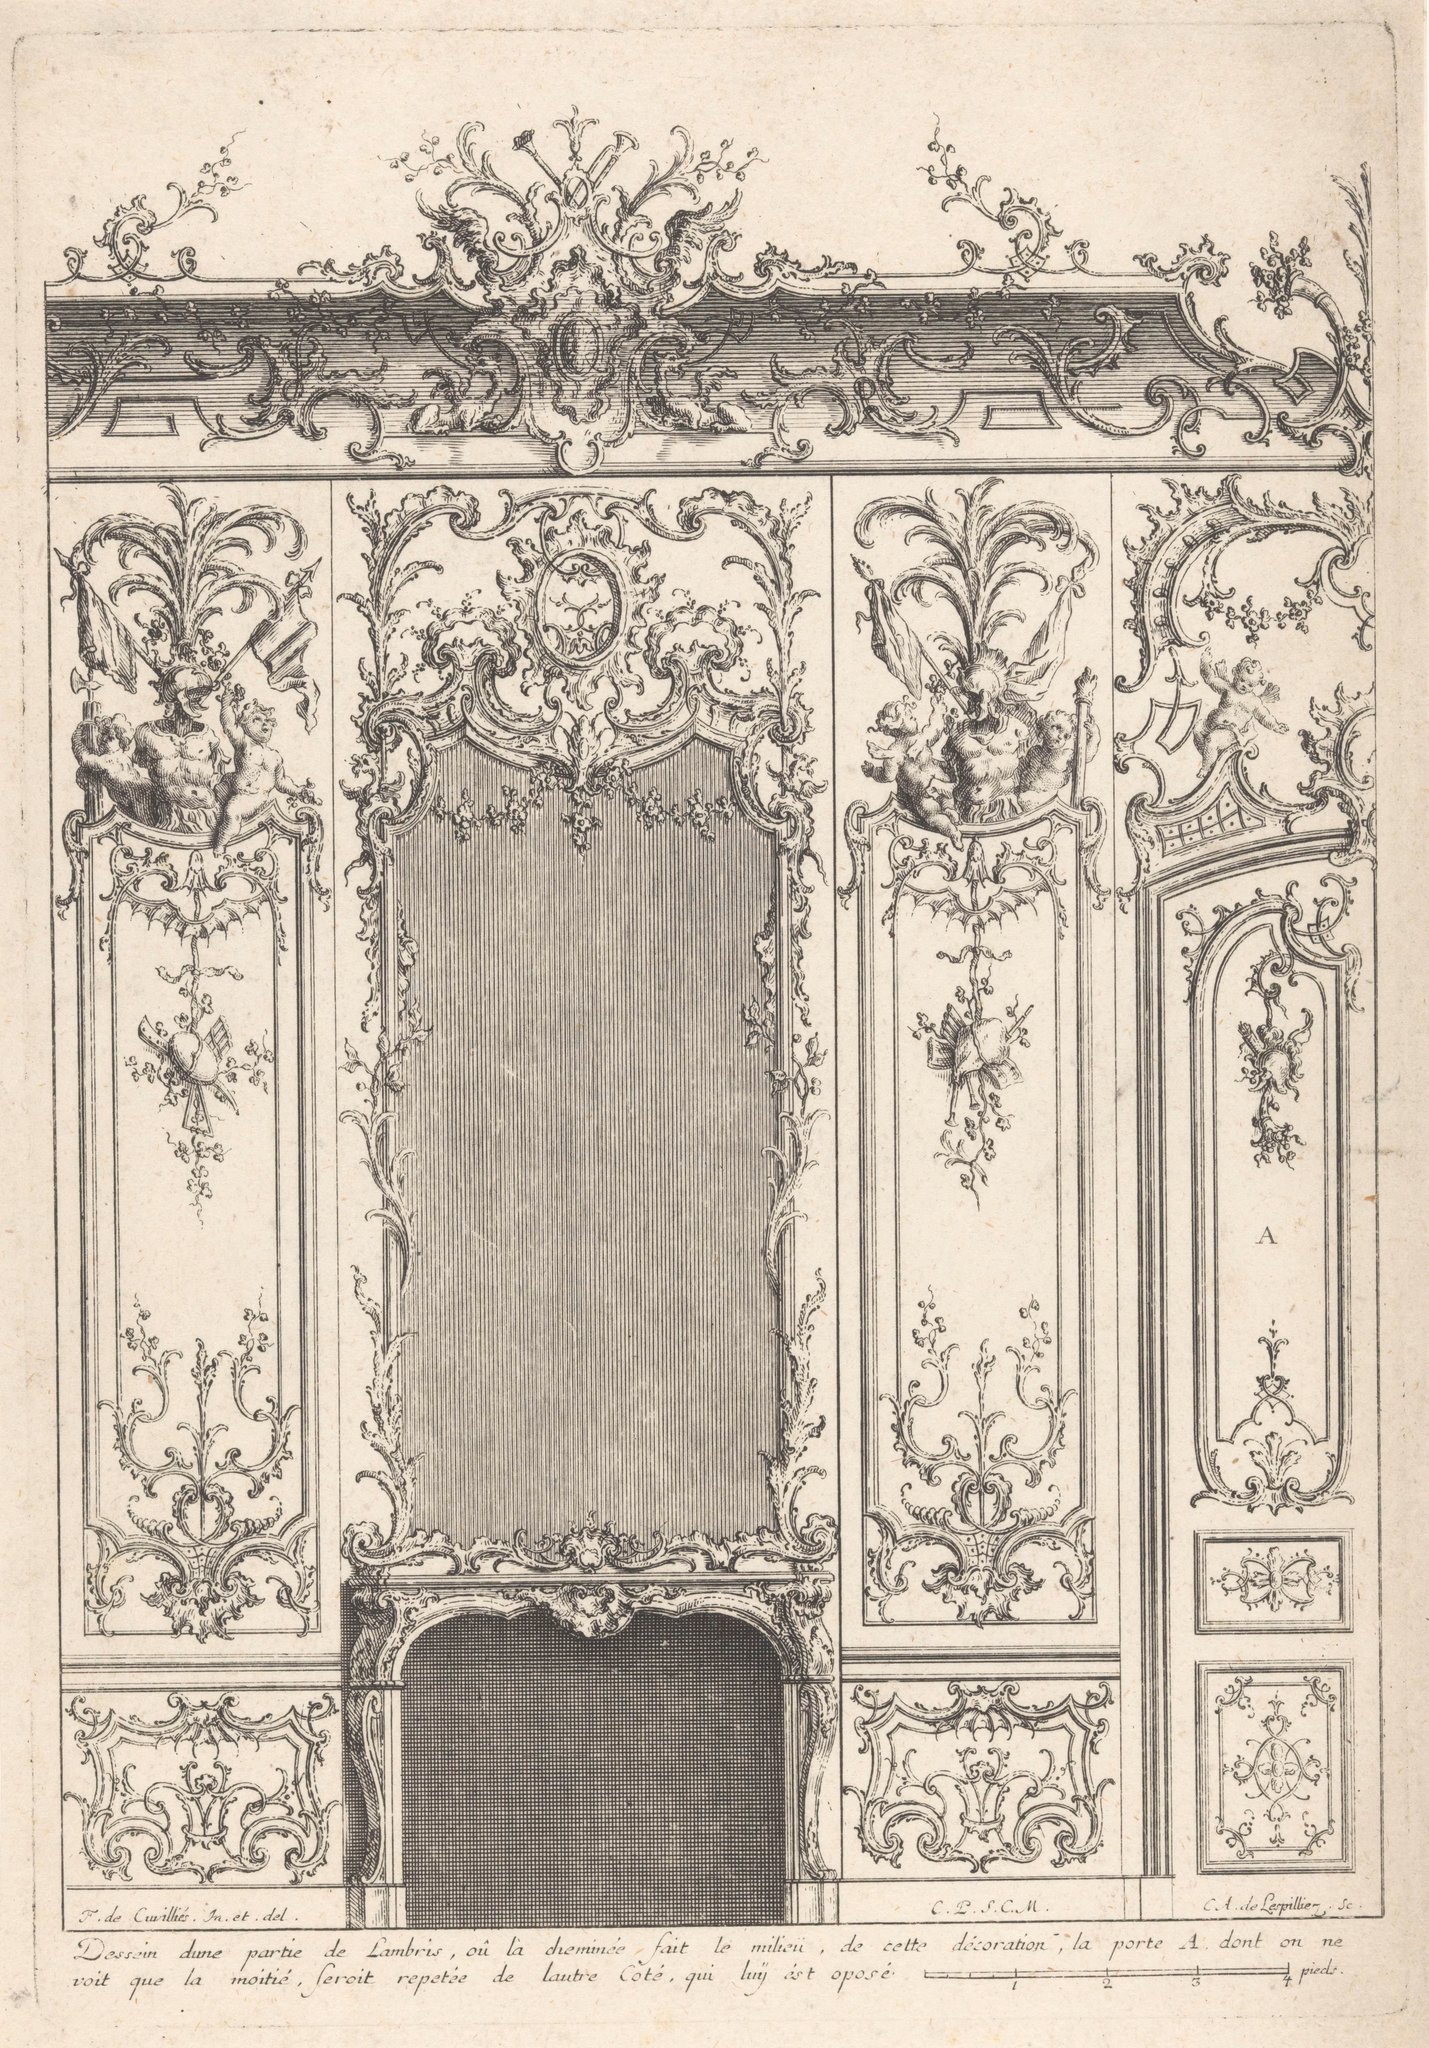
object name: ornament print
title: 23 Livre de Lambris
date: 1738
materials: paper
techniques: etching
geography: germany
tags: rocaille ornament, panelling, armour, open hearth, fire-place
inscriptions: collector's mark: Lugt 2228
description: Een geornamenteerde schouw met rocaille ornamenten, links en rechts geornamenteerde panelen met rocailles, putti en harnassen.